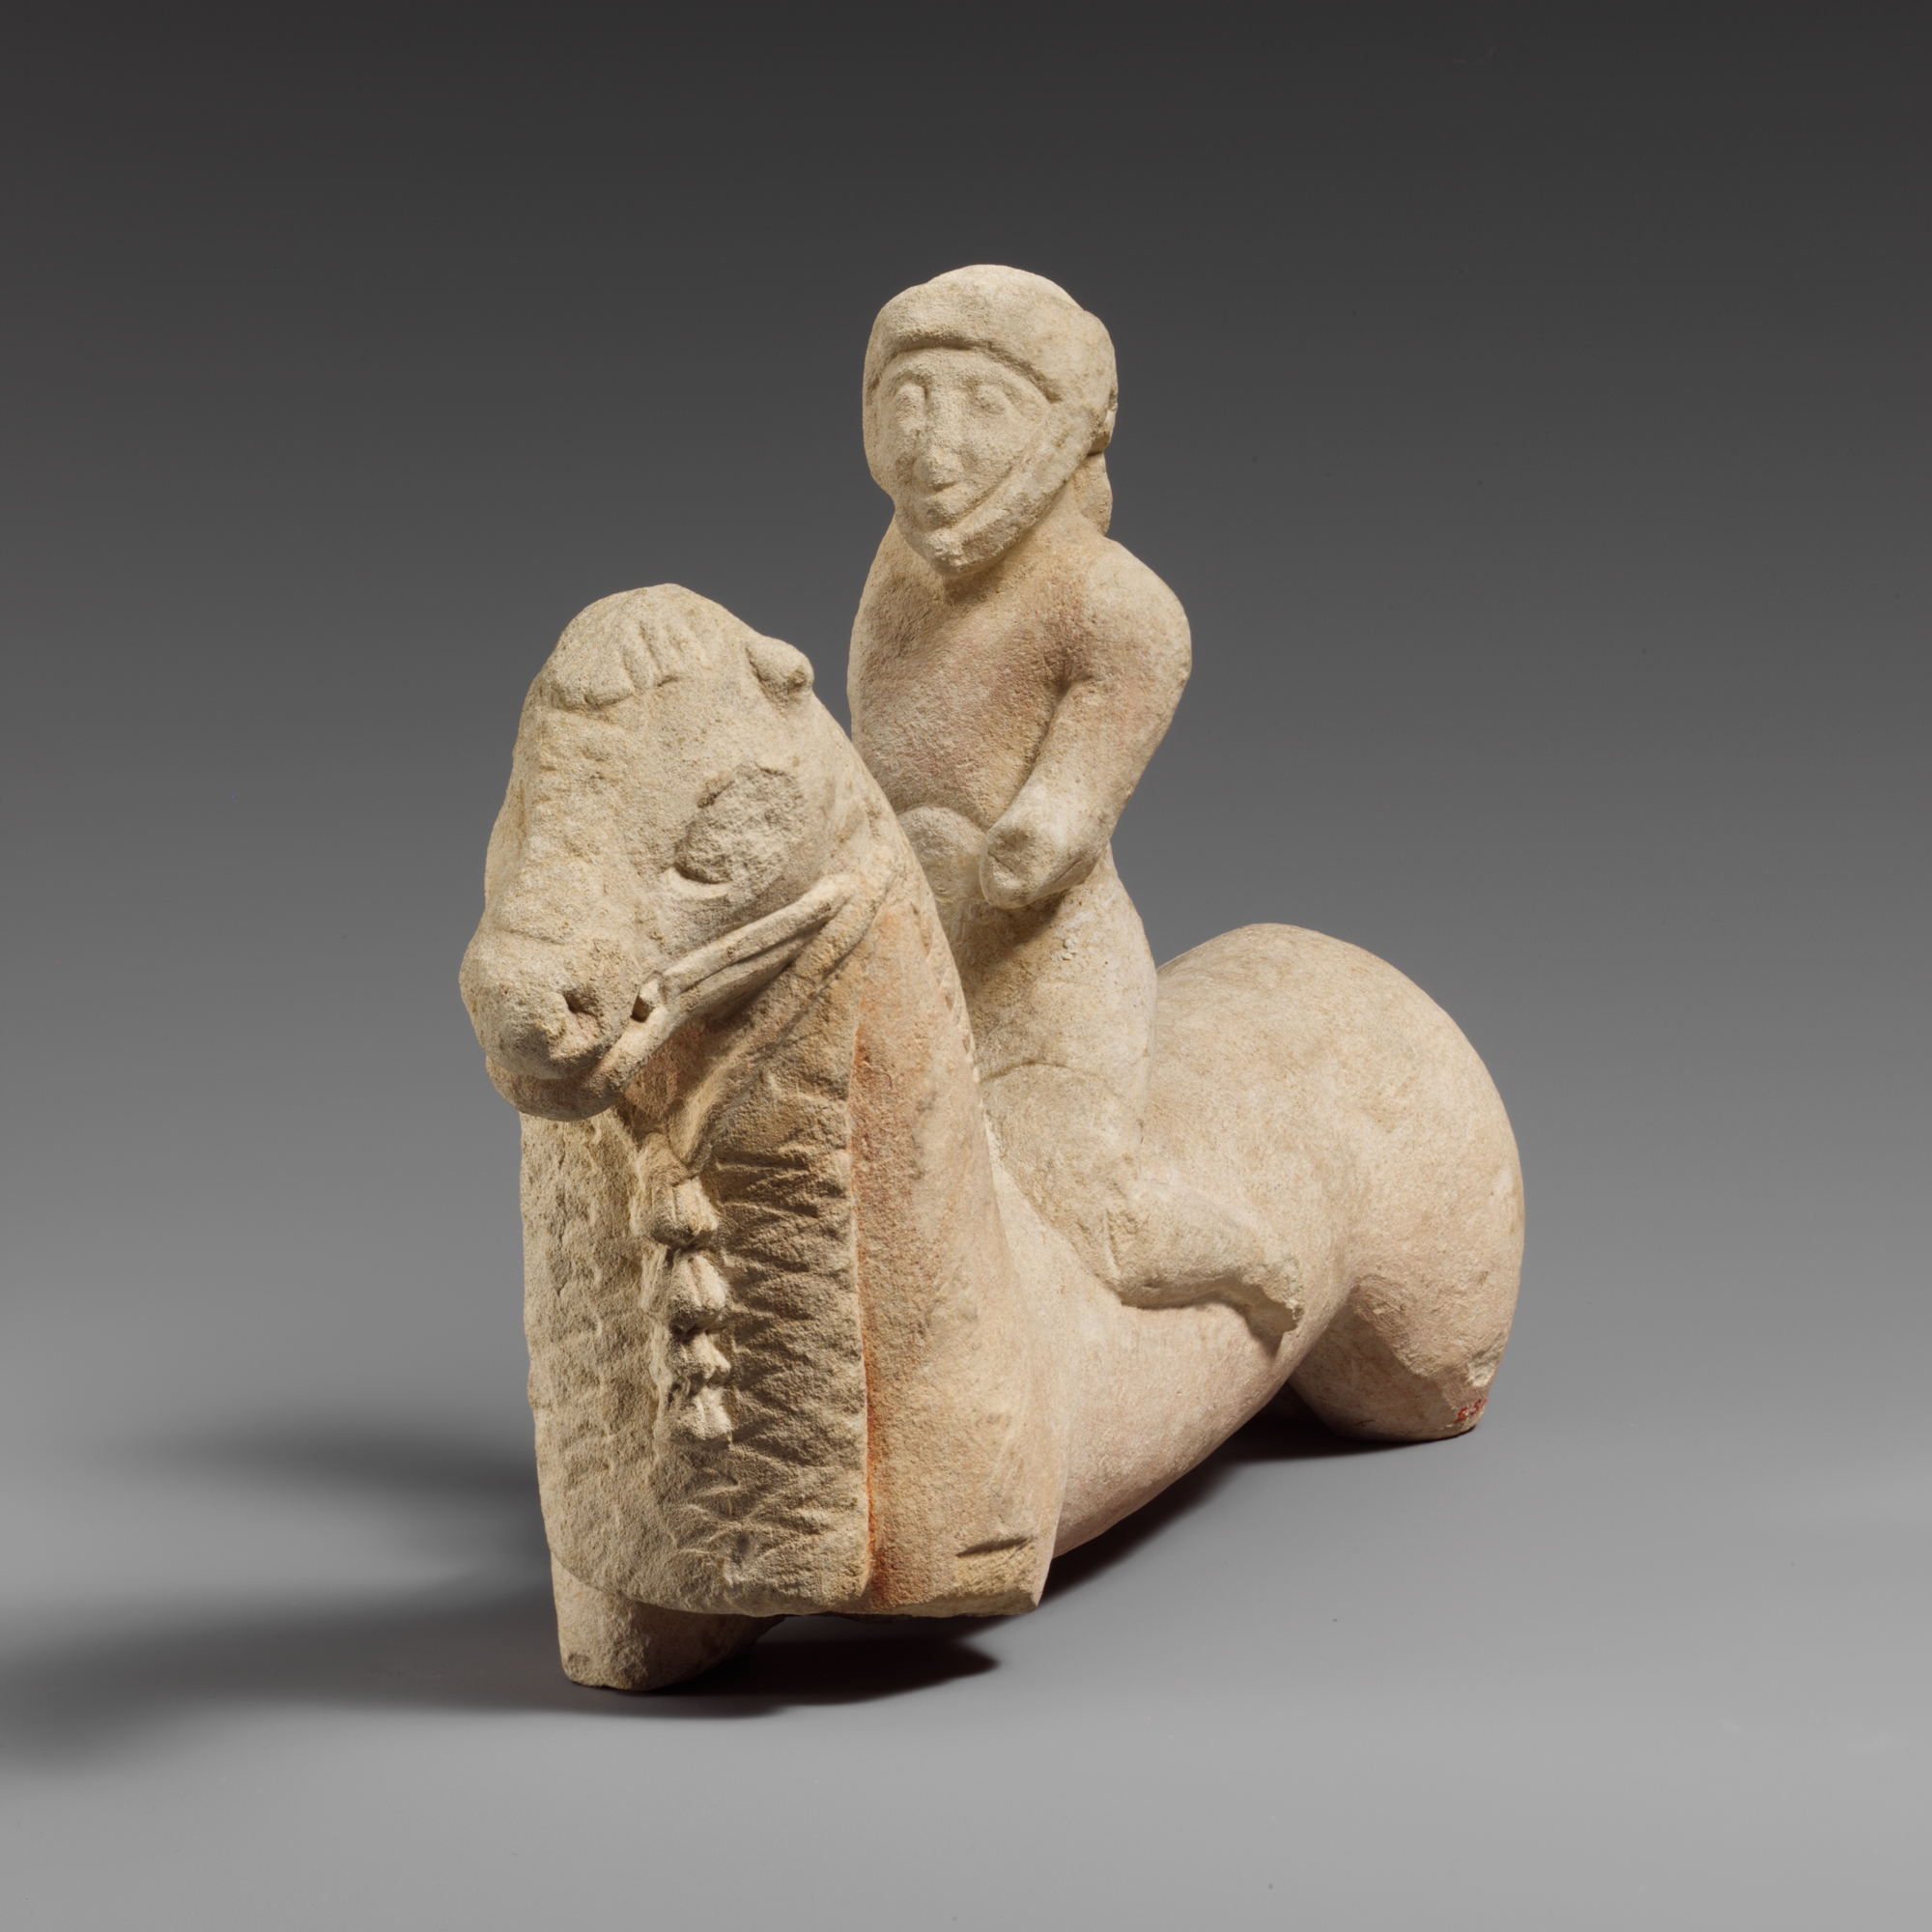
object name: statuette of a horse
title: Limestone horse with a rider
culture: cypriot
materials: limestone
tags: horses